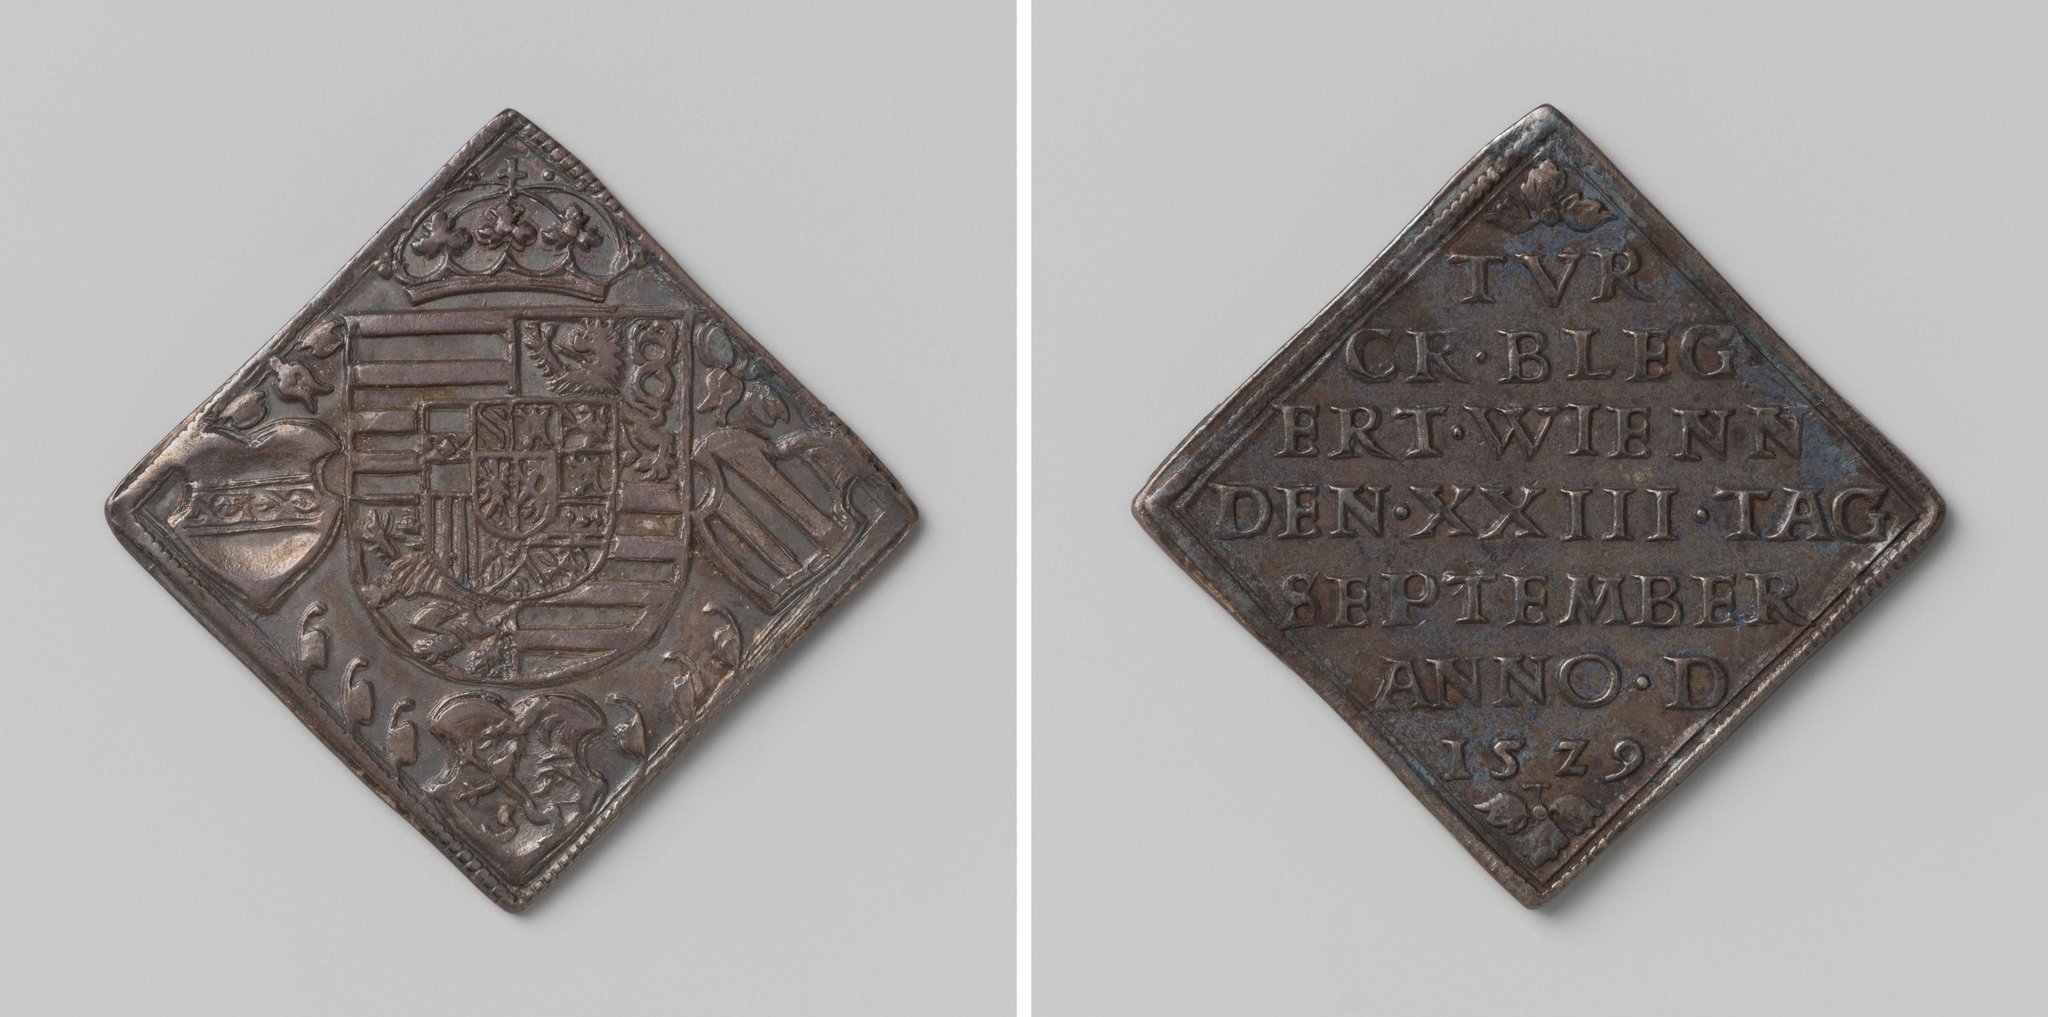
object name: coin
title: Herinneringspenning over het beleg van Wenen door de Turken, in de vorm van een noodmunt van een kwart taler.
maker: Anonymous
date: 1529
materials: silver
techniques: striking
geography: vienna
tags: vienna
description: ruitvormige noodmunt. Voorzijde: gekroond wapenschild; links, rechts en beneden: wapenschild. Keerzijde: opschrift onder en boven bloemknop